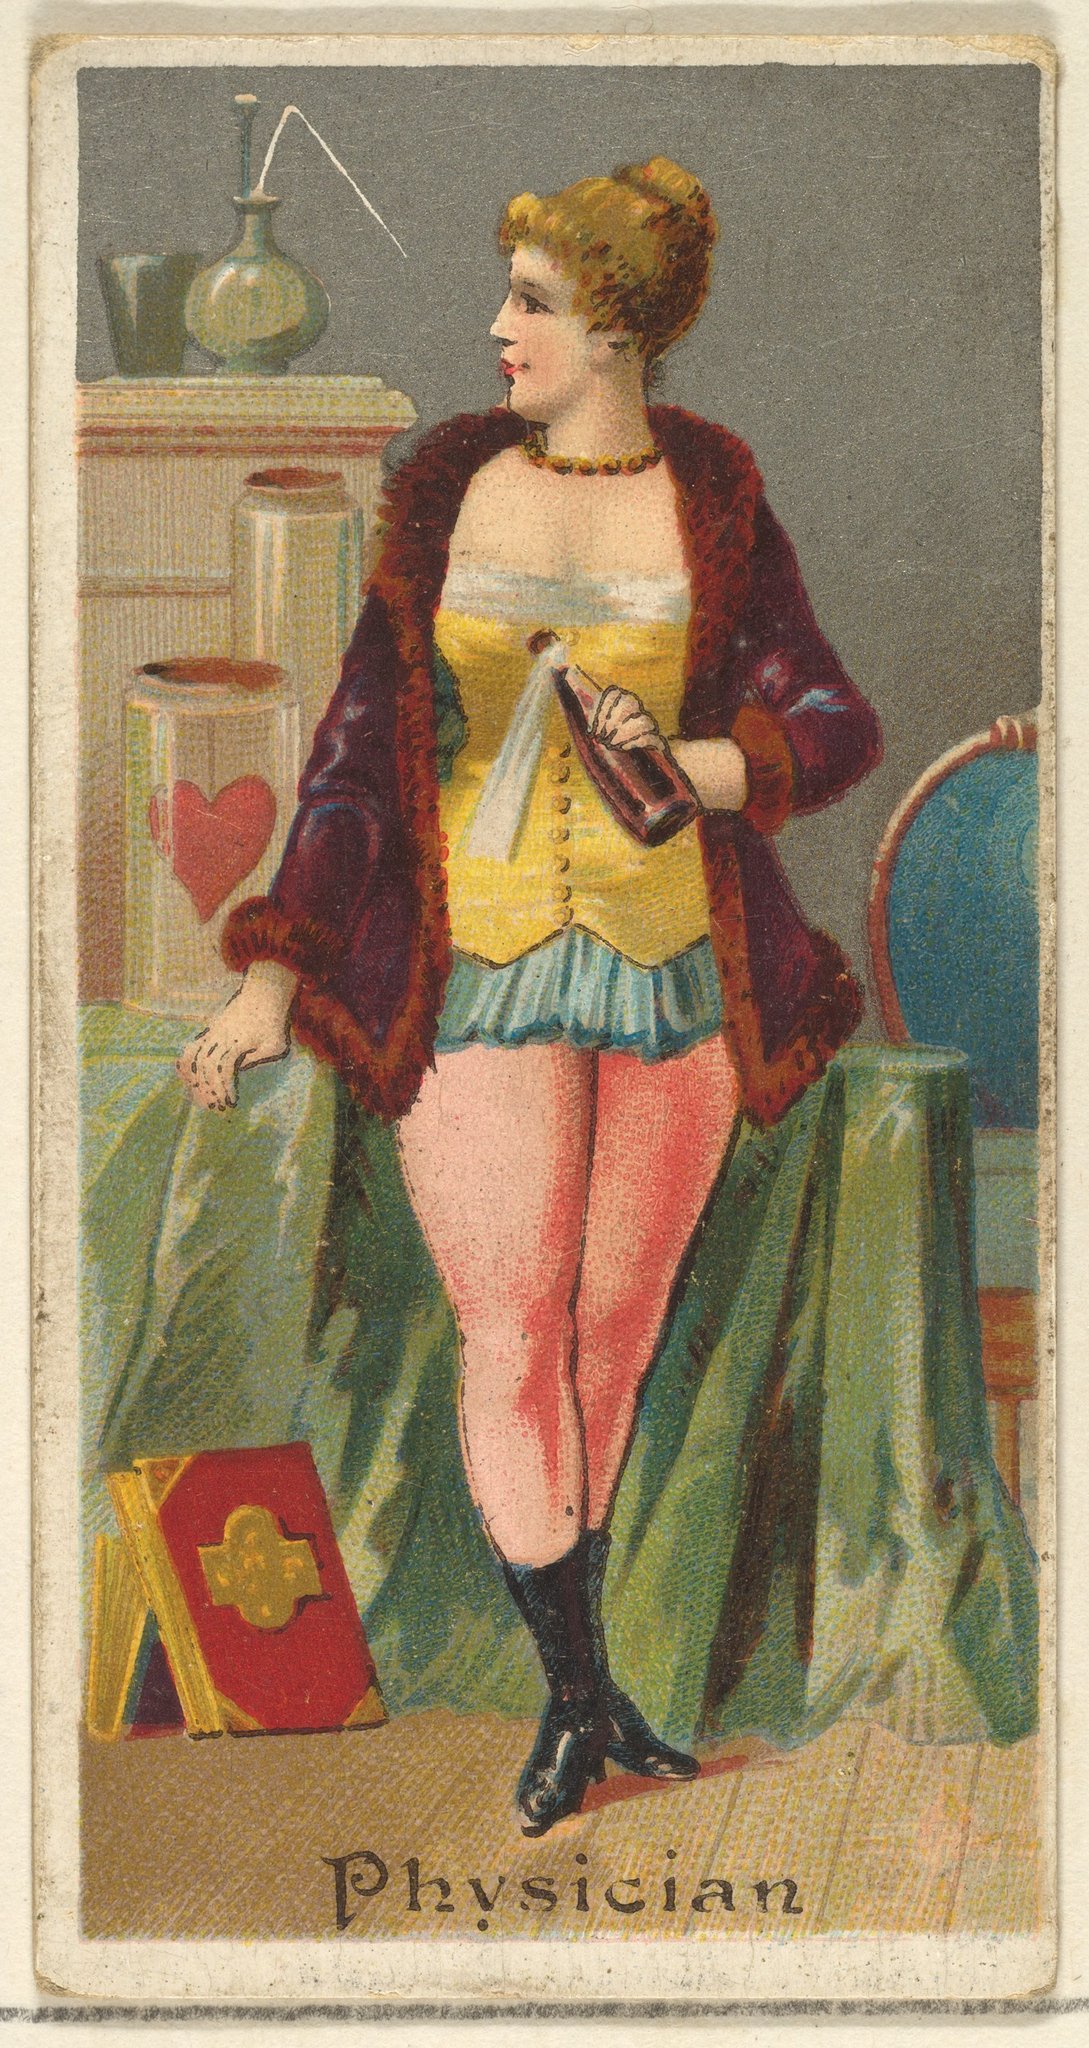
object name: print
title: Physician, from the Occupations for Women series (N166) for Old Judge and Dogs Head Cigarettes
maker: goodwin & company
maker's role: publisher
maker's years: 1850-1950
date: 1887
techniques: color lithograph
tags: women,doctors